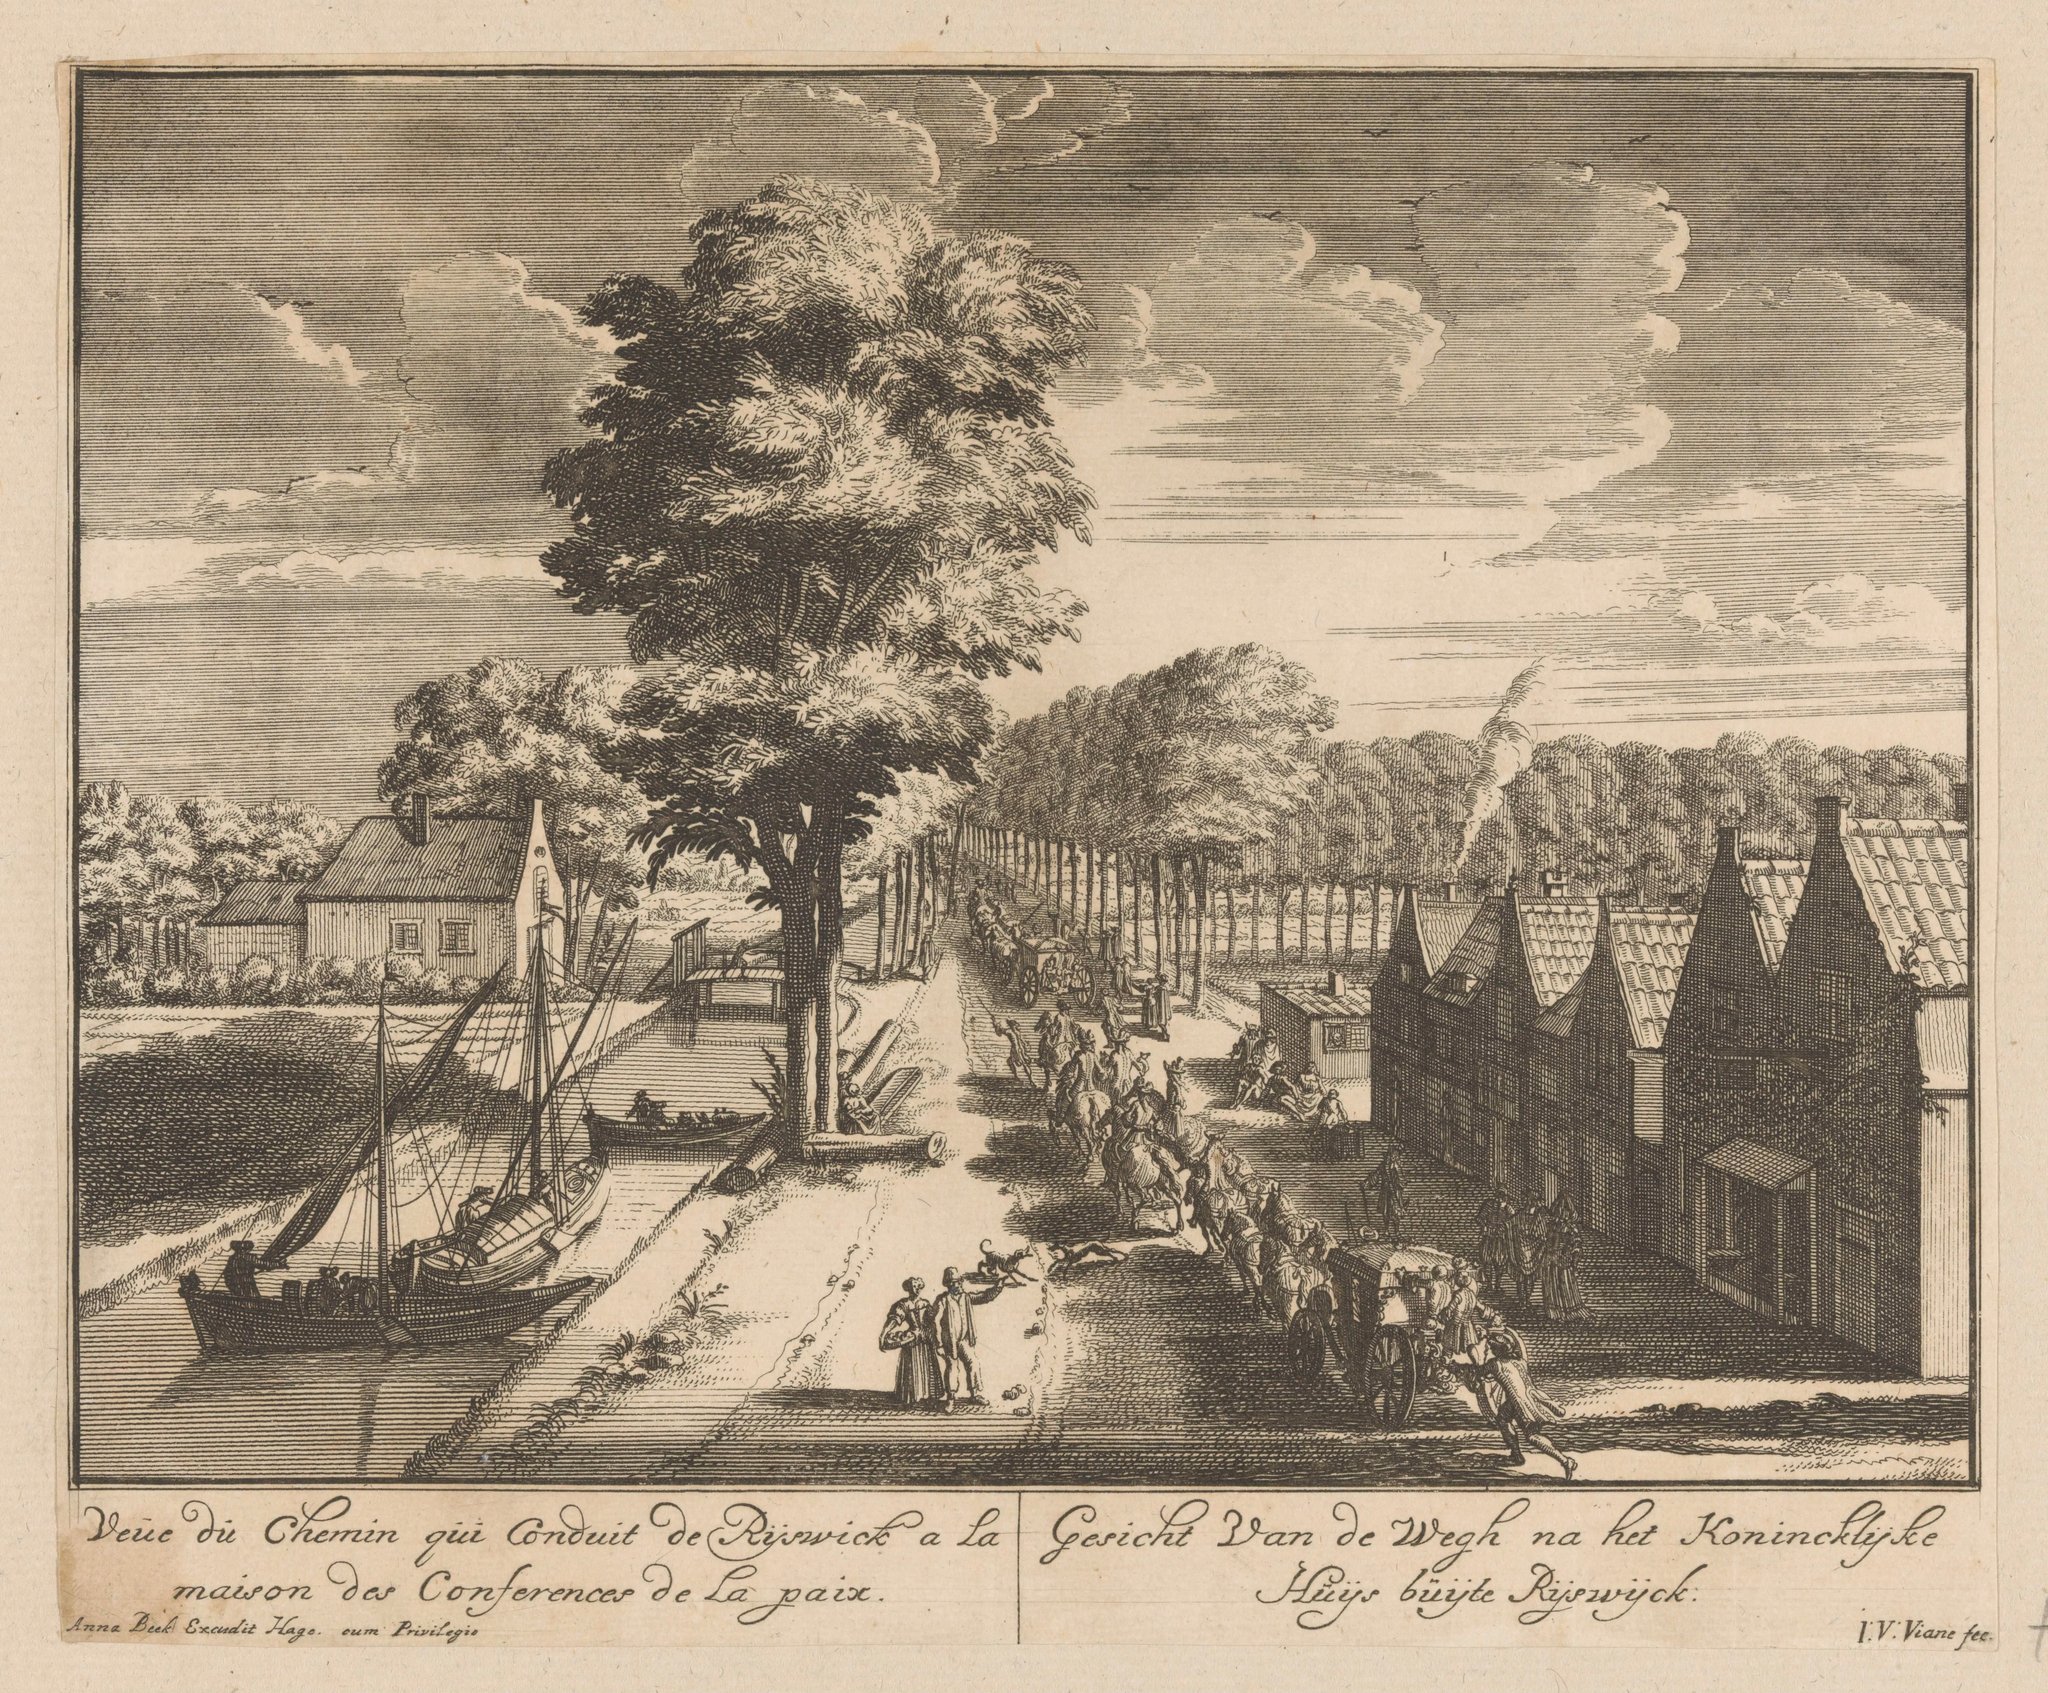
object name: print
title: De weg naar het Huis ter Nieuburch in Rijswijk, 1697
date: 1697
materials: paper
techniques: etching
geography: the hague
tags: rijswijk, huis ter nieuburch, vrede van rijswijk (1697)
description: De weg naar het Huis ter Nieuburch in Rijswijk. In het onderschrift de twee titels in het Frans en Nederlands. Onderdeel (prent 1) van de serie van vijftien prenten over het Huis ter Nieuburch in Rijswijk en de daar gehouden vredesonderhandelingen resulterend in de Vrede van Rijswijk gesloten op 20 september 1697.